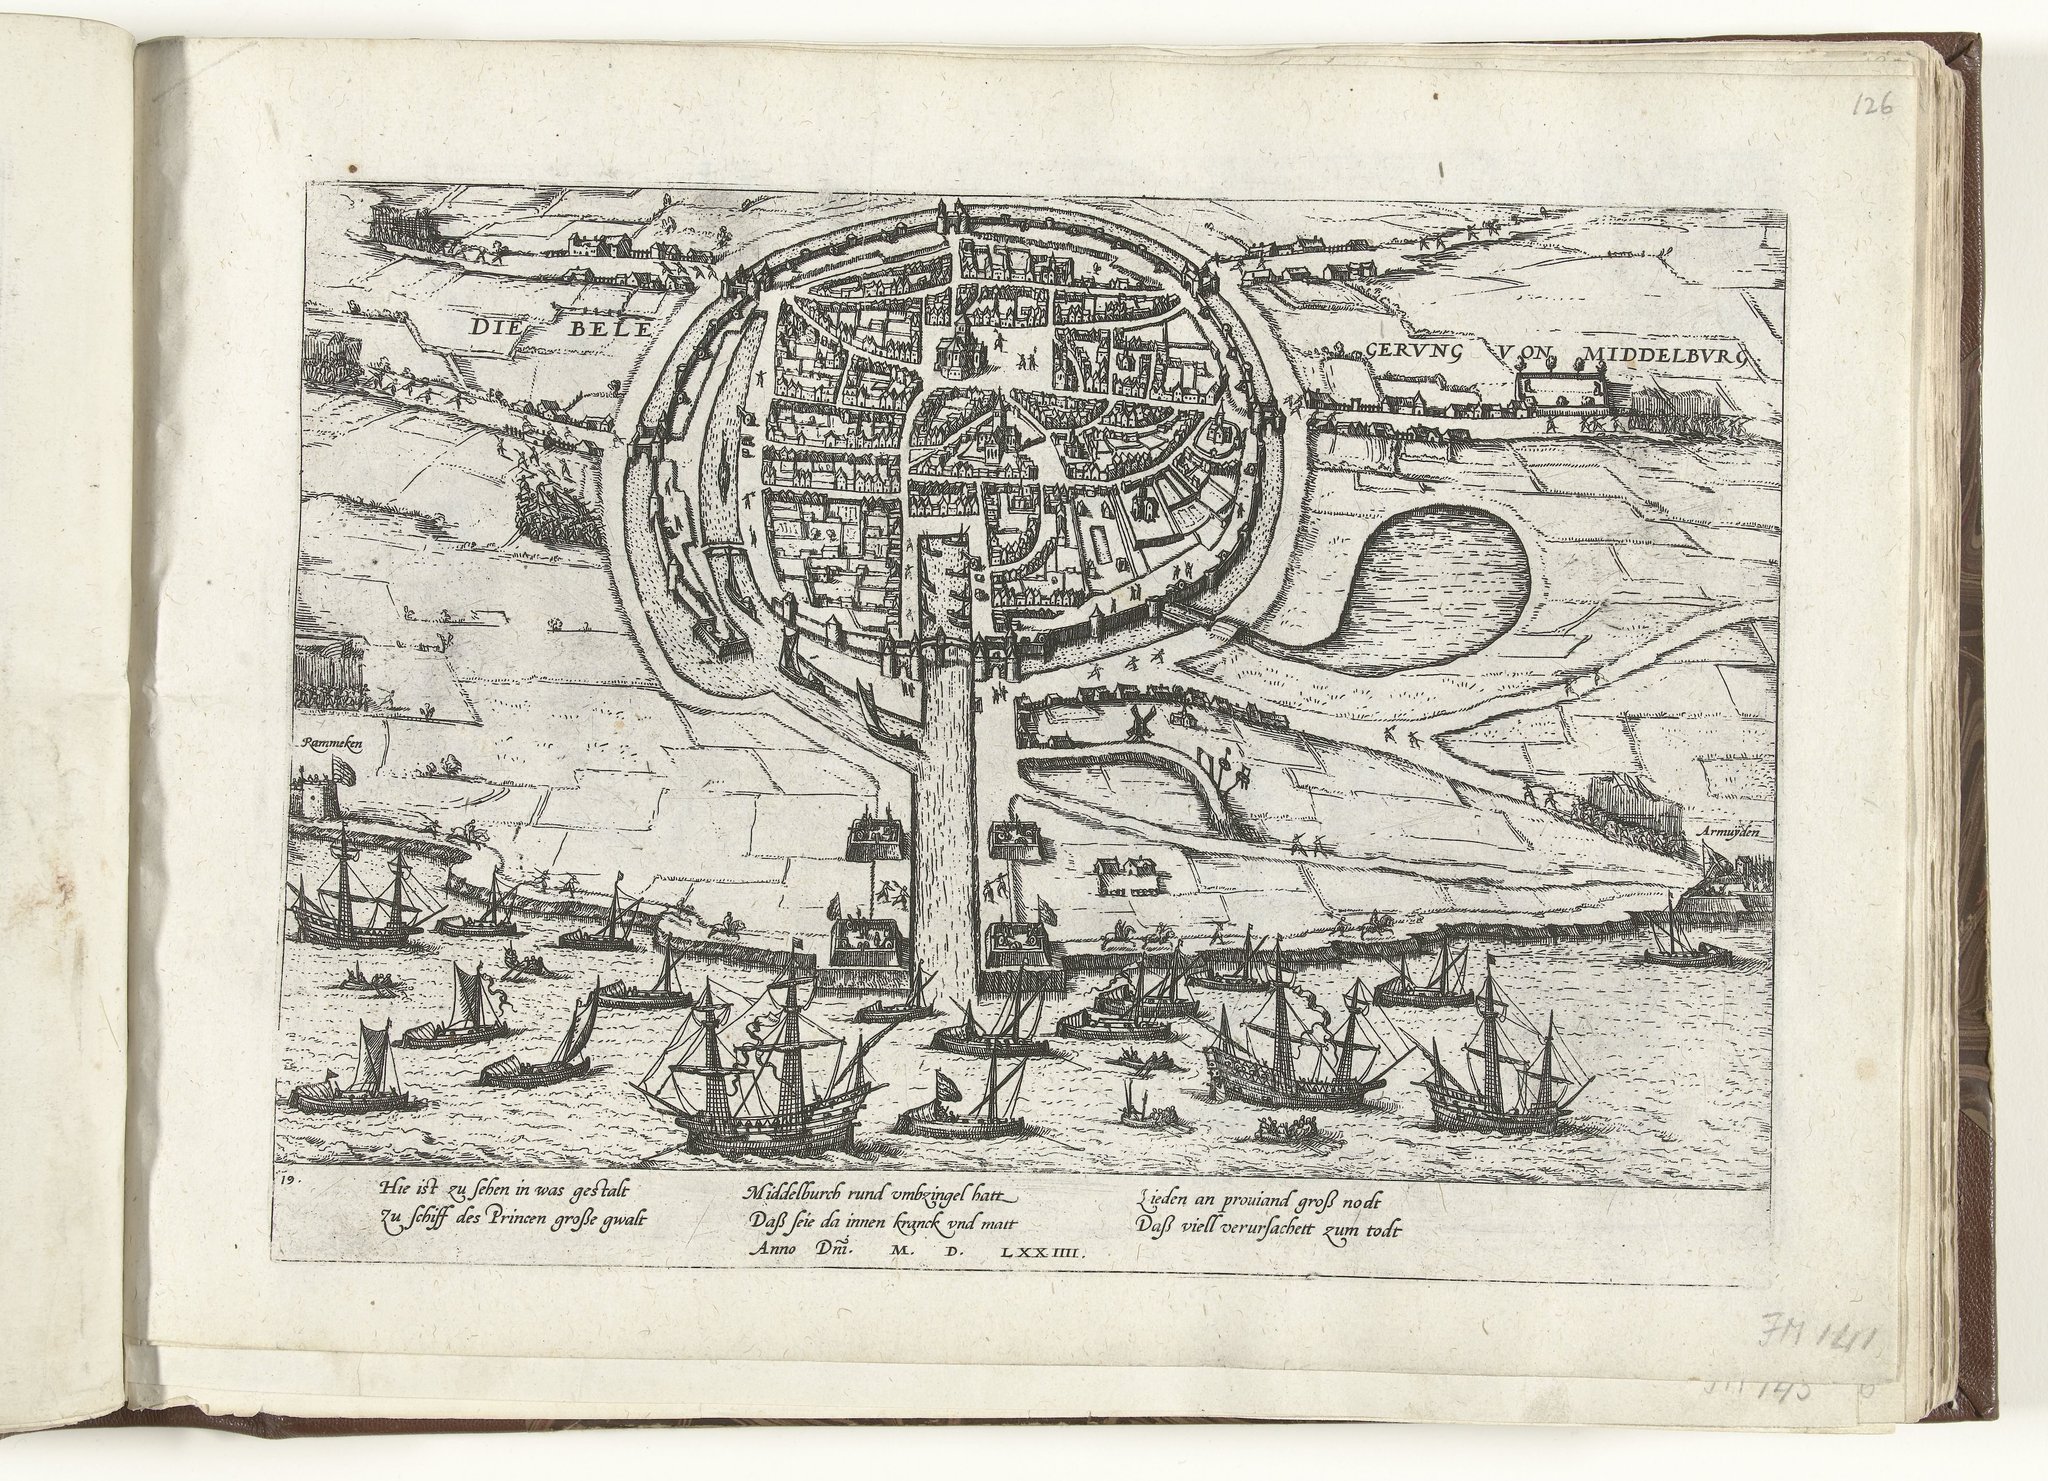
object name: album leaf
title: Serie 6: Nederlandse Gebeurtenissen, 1571-1576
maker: frans hogenberg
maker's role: print maker, publisher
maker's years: 1538-1590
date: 1574-1576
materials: paper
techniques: etching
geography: cologne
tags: siege, position war, middelburg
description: Beleg van Middelburg door de opstandelingen, januari 1574. Gezicht op de belegerde stad en de omgeving. Op de voorgrond de schepen van de geuzen, Fort Rammekens en Arnemuiden. Met onderschrift van 6 regels in het Duits. Genummerd: 19.